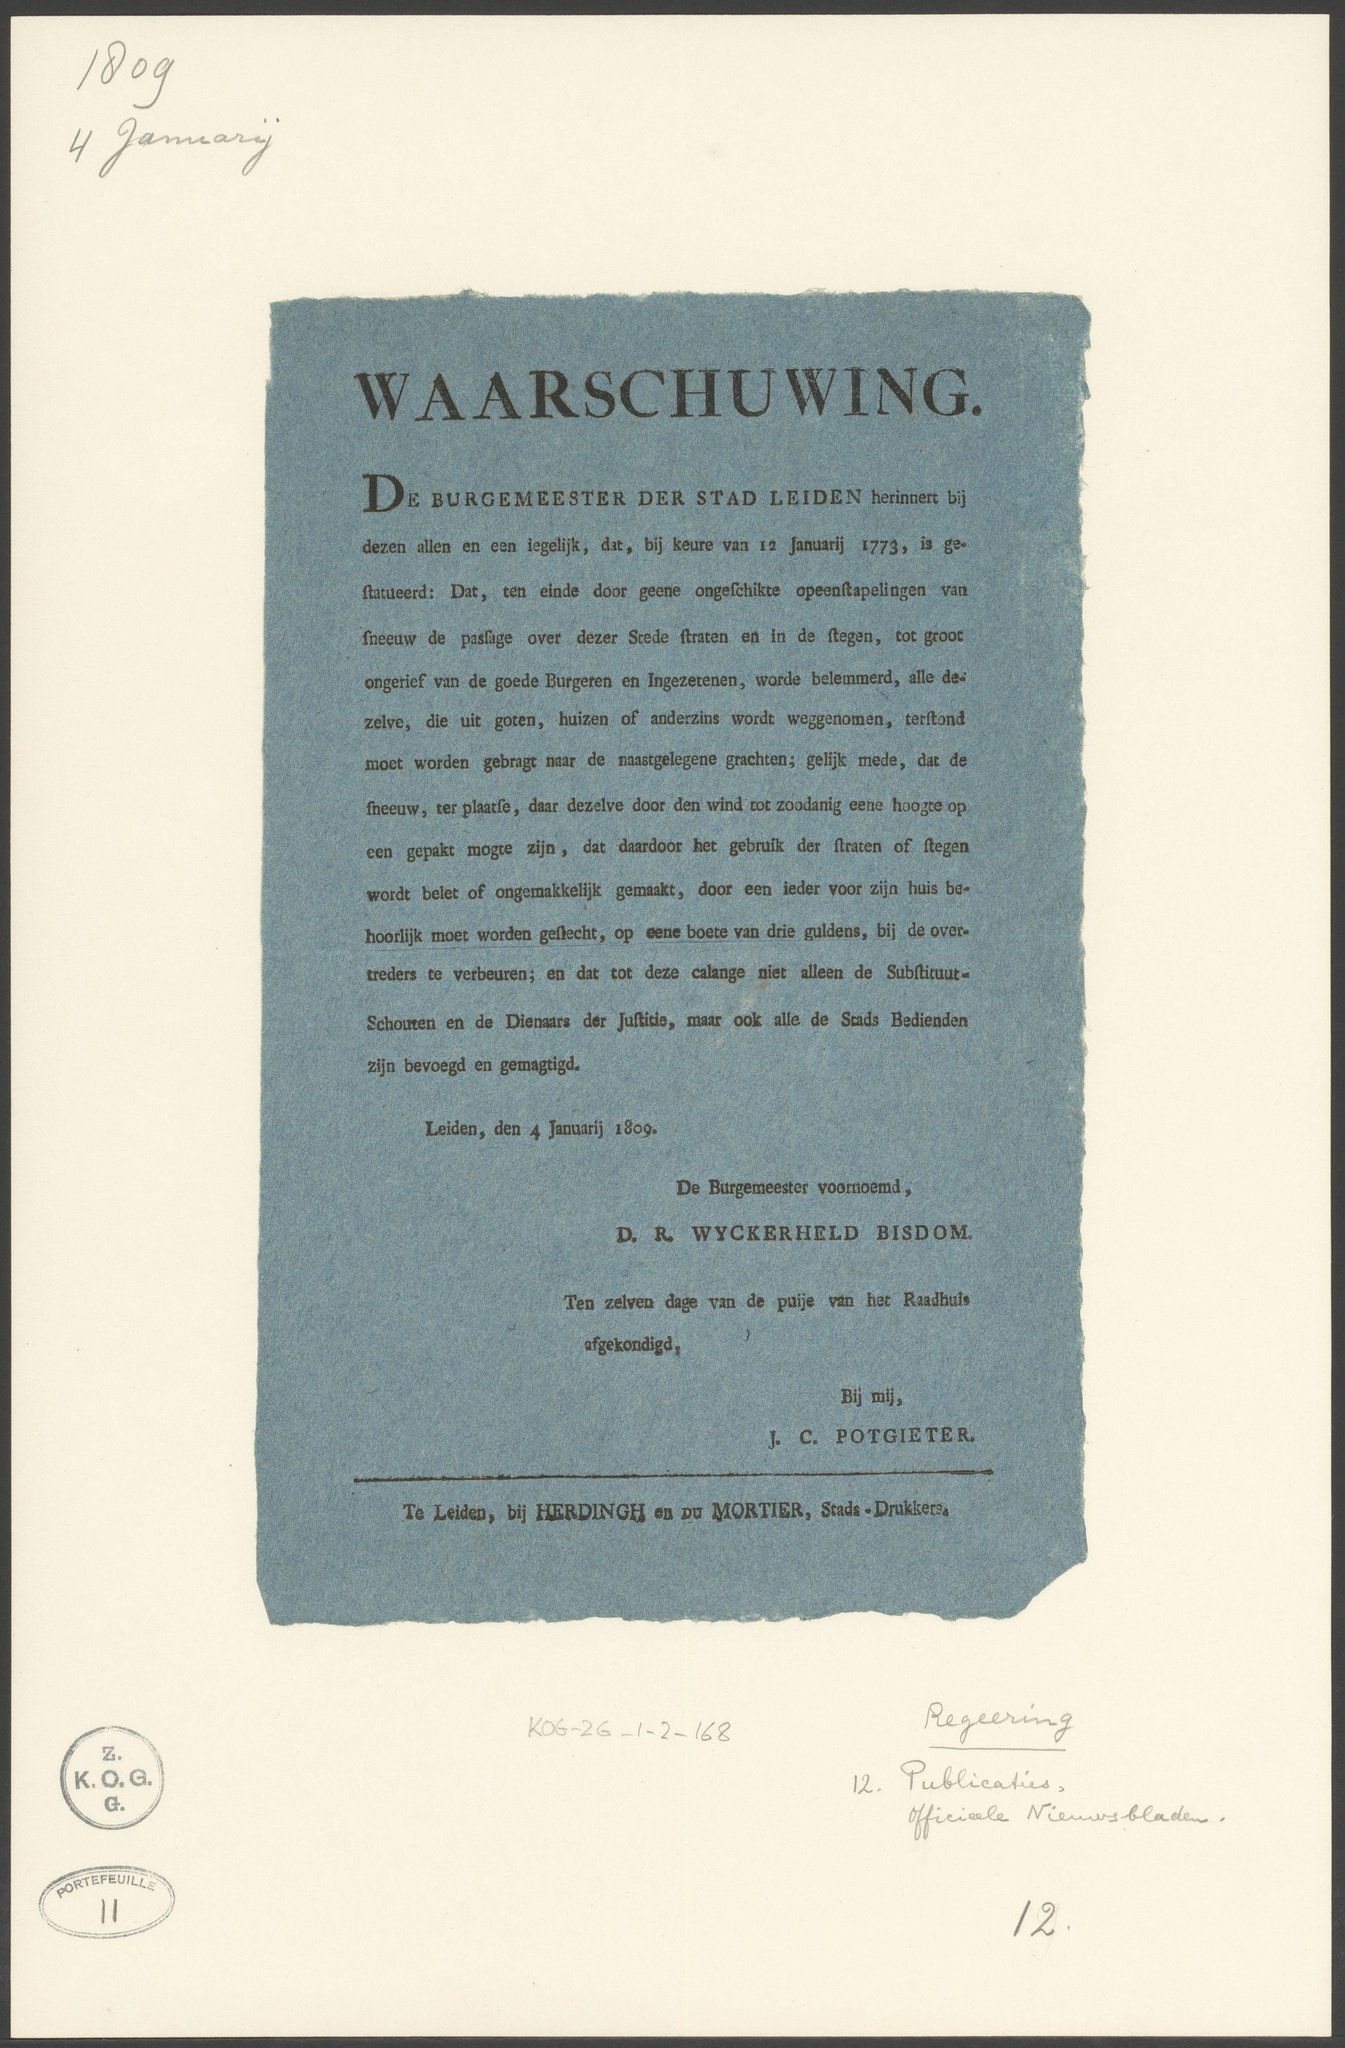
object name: publication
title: Waarschuwing over sneeuwruimen, 1809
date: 1809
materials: paper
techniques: letterpress printing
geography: leiden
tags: government services, public services, snow, leiden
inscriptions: collector's mark: Lugt 1641, collector's mark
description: Waarschuwing met de herinnering aan de keur uit 1773 over de verplichting om de stoepen en straten sneeuwvrij te maken, Leiden, 4 januari 1809. Gedrukte tekst op blauw papier. Onderwerpsrubrieken binnen de Atlas Zeden en Gewoonten: Regeering, Publicaties.